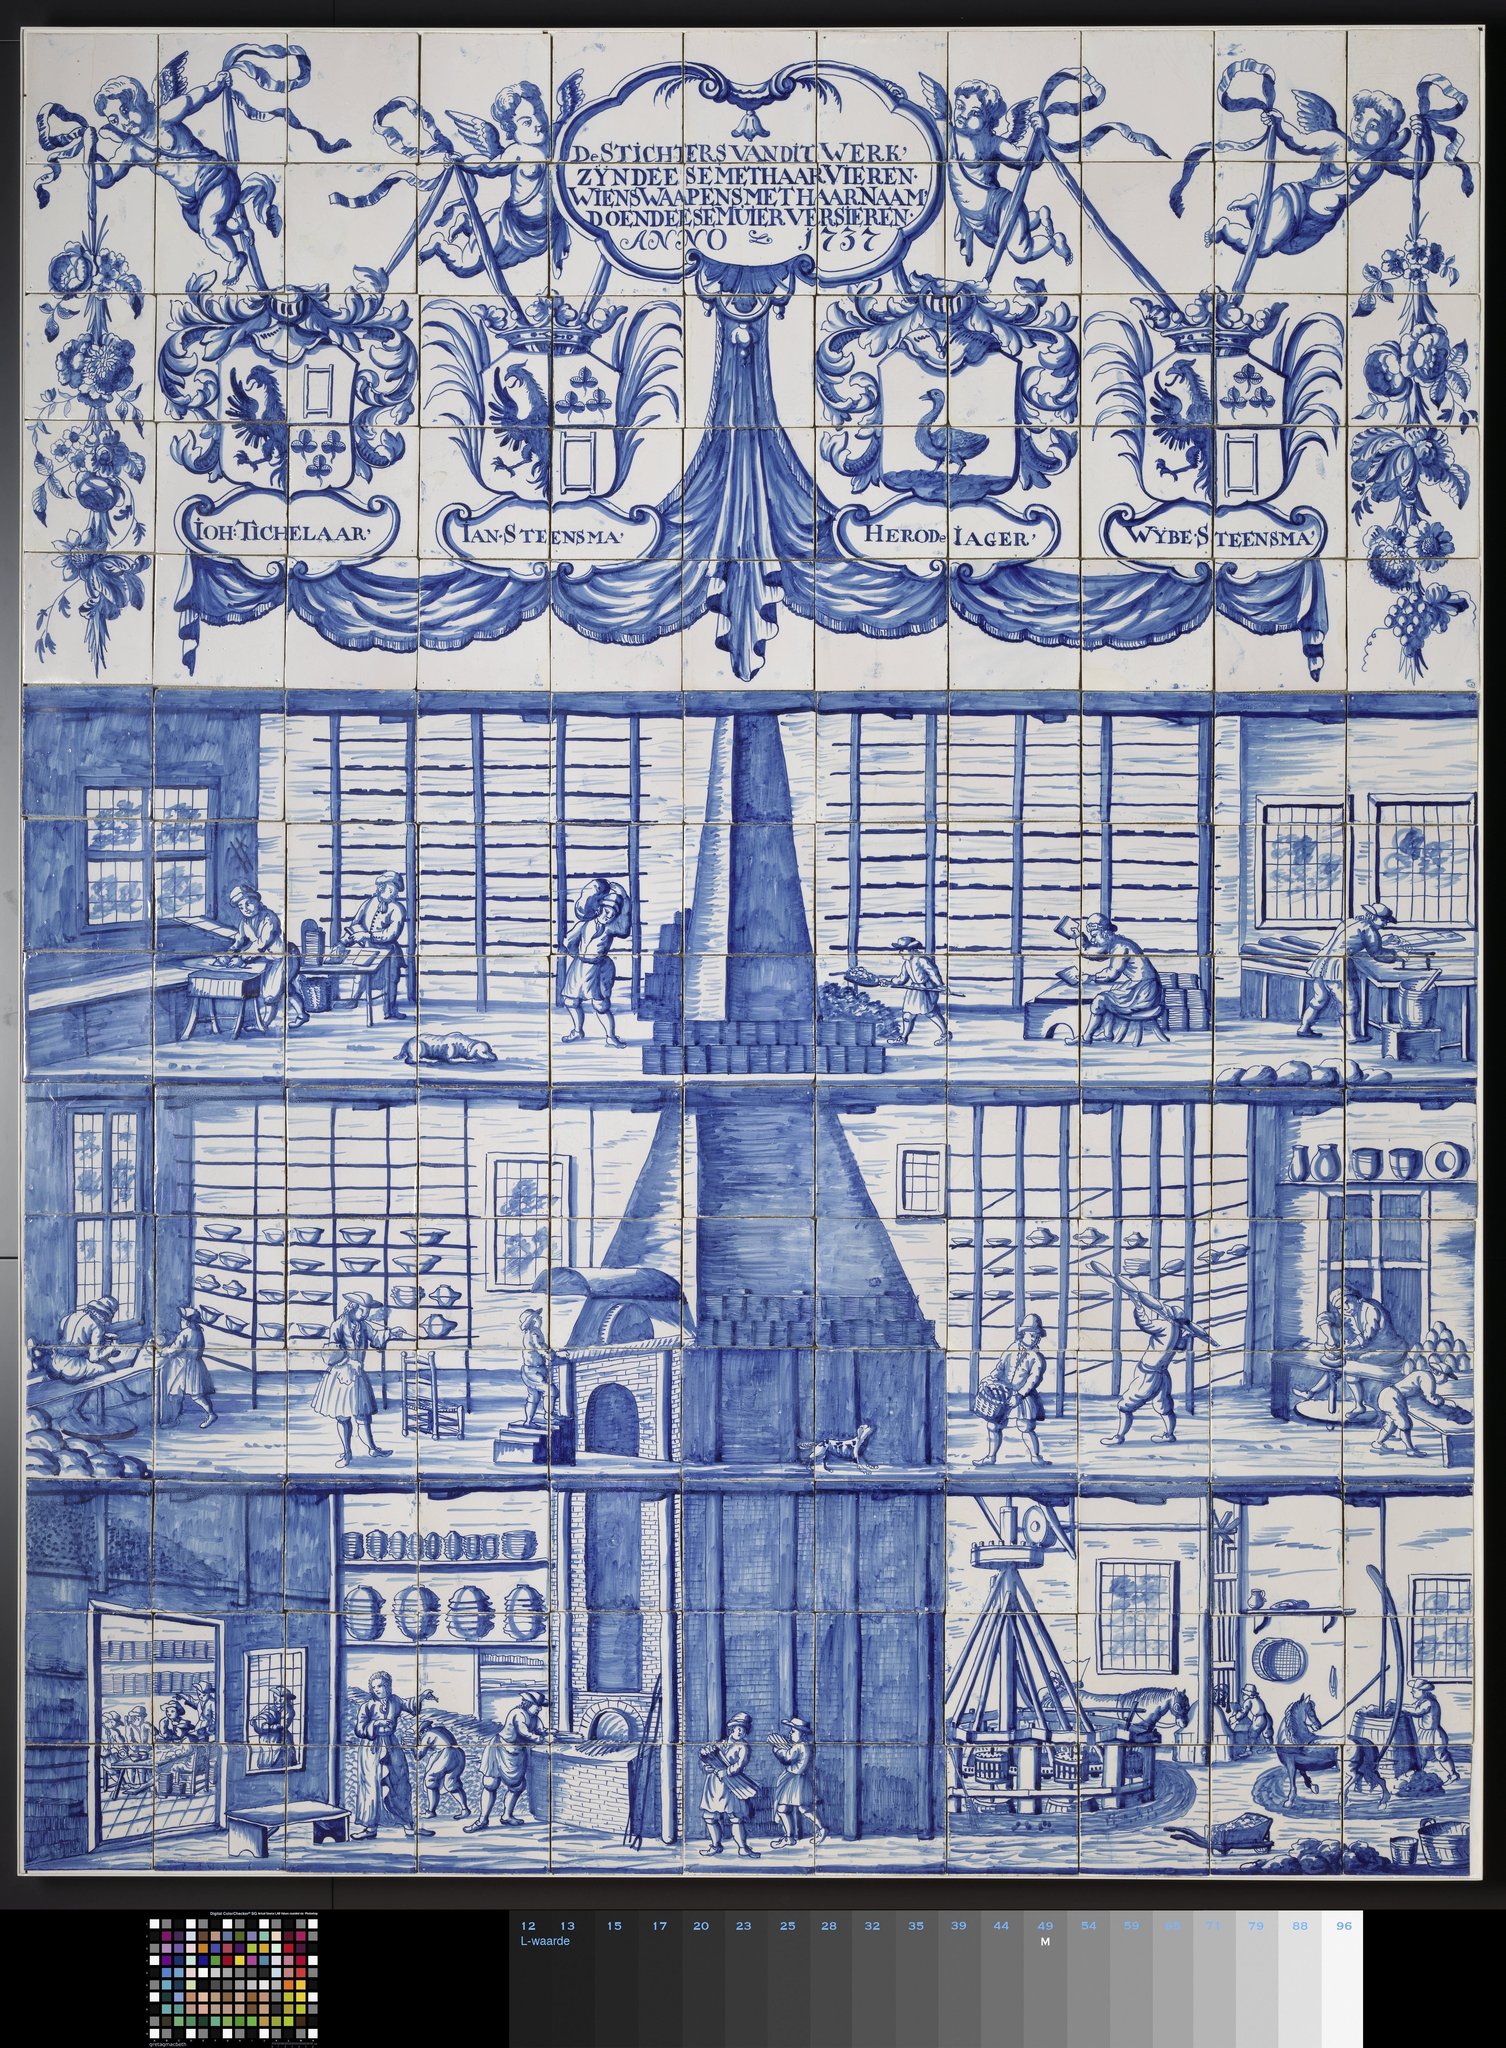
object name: tile tableau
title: Tile panel with the tile and pottery factory in Bolsward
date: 1745-1765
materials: earthenware, glaze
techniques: maiolica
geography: harlingen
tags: tiles, bricks ~ building material (+ before and after production)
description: This large panel was made to commemorate the founding of the tile and pottery factory in Bolsward in 1737. It shows a section through a factory, with the stokers, the painters and the clay mills on the ground floor. On the first floor is the potters’ loft, on the second floor the tilers’ loft. The huge kiln extends through the three floors.